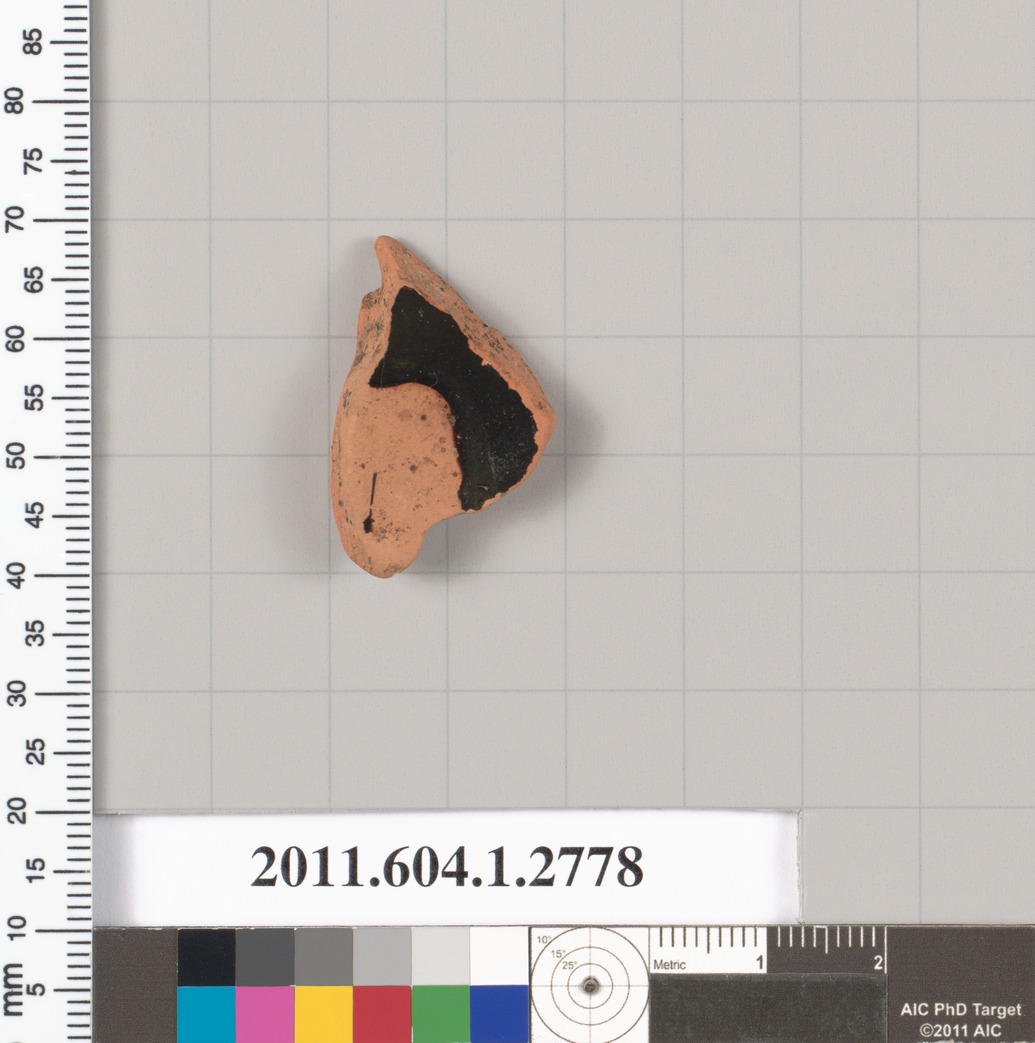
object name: kylix fragment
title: Terracotta fragment of a kylix (drinking cup)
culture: greek, attic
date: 500-401 BCE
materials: terracotta